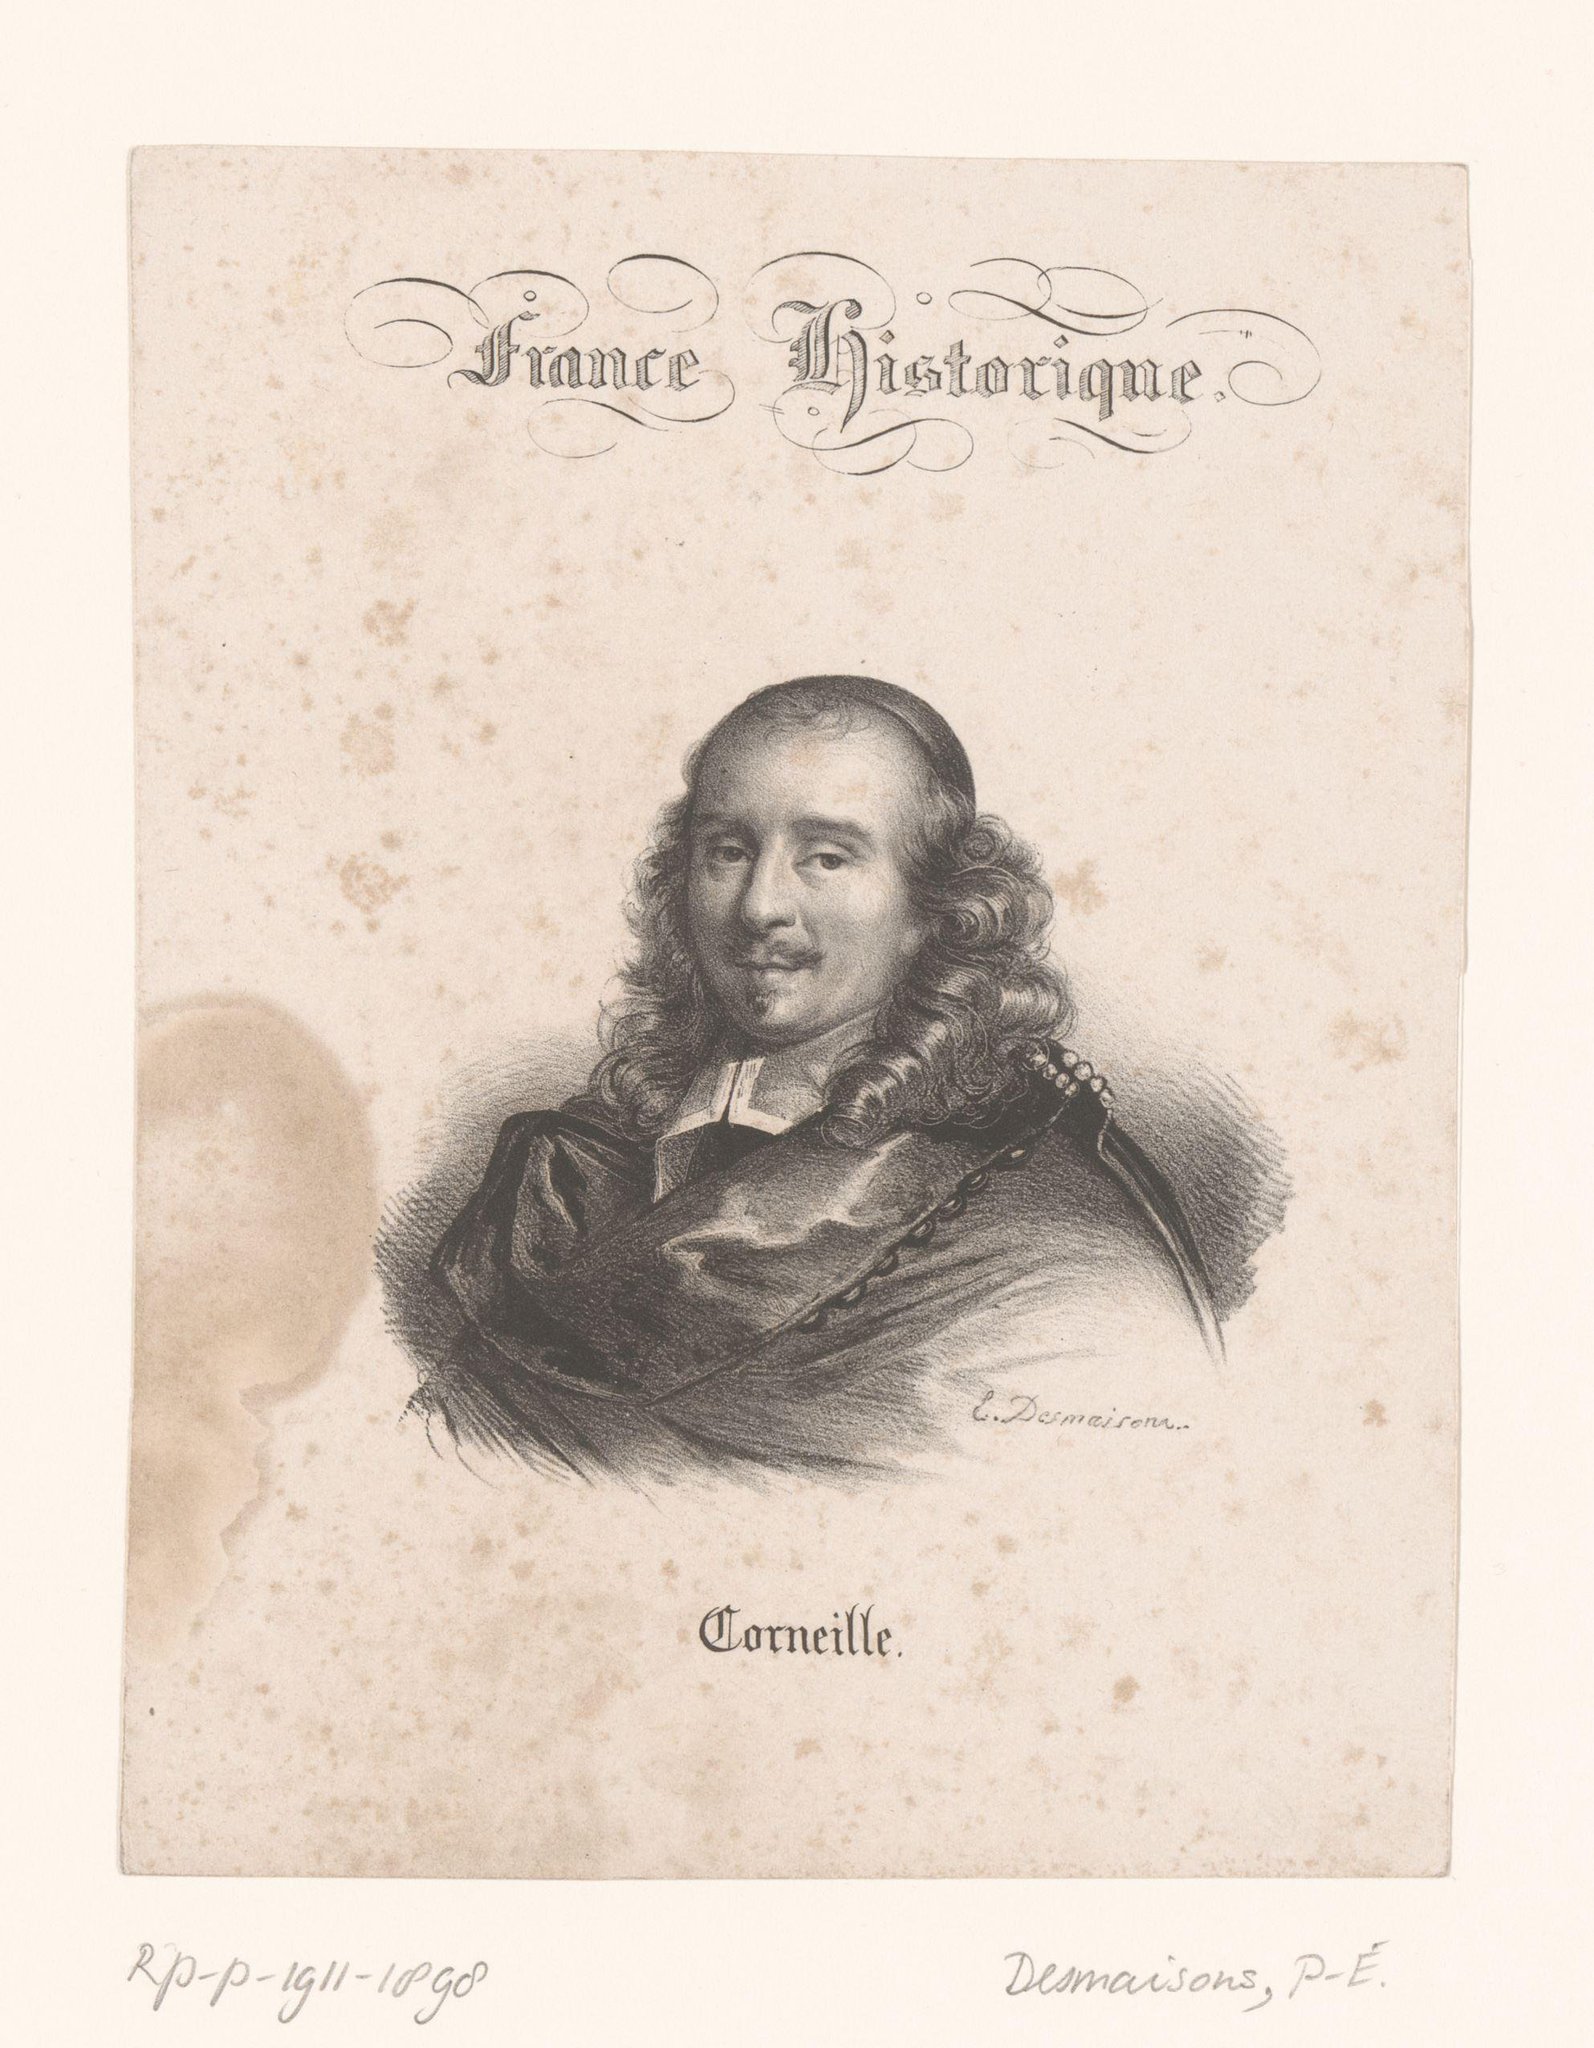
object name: print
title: Corneille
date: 1836-1837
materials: paper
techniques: lithograph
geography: paris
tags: pierre corneille, historical persons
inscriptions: collector's mark: Lugt 2228a